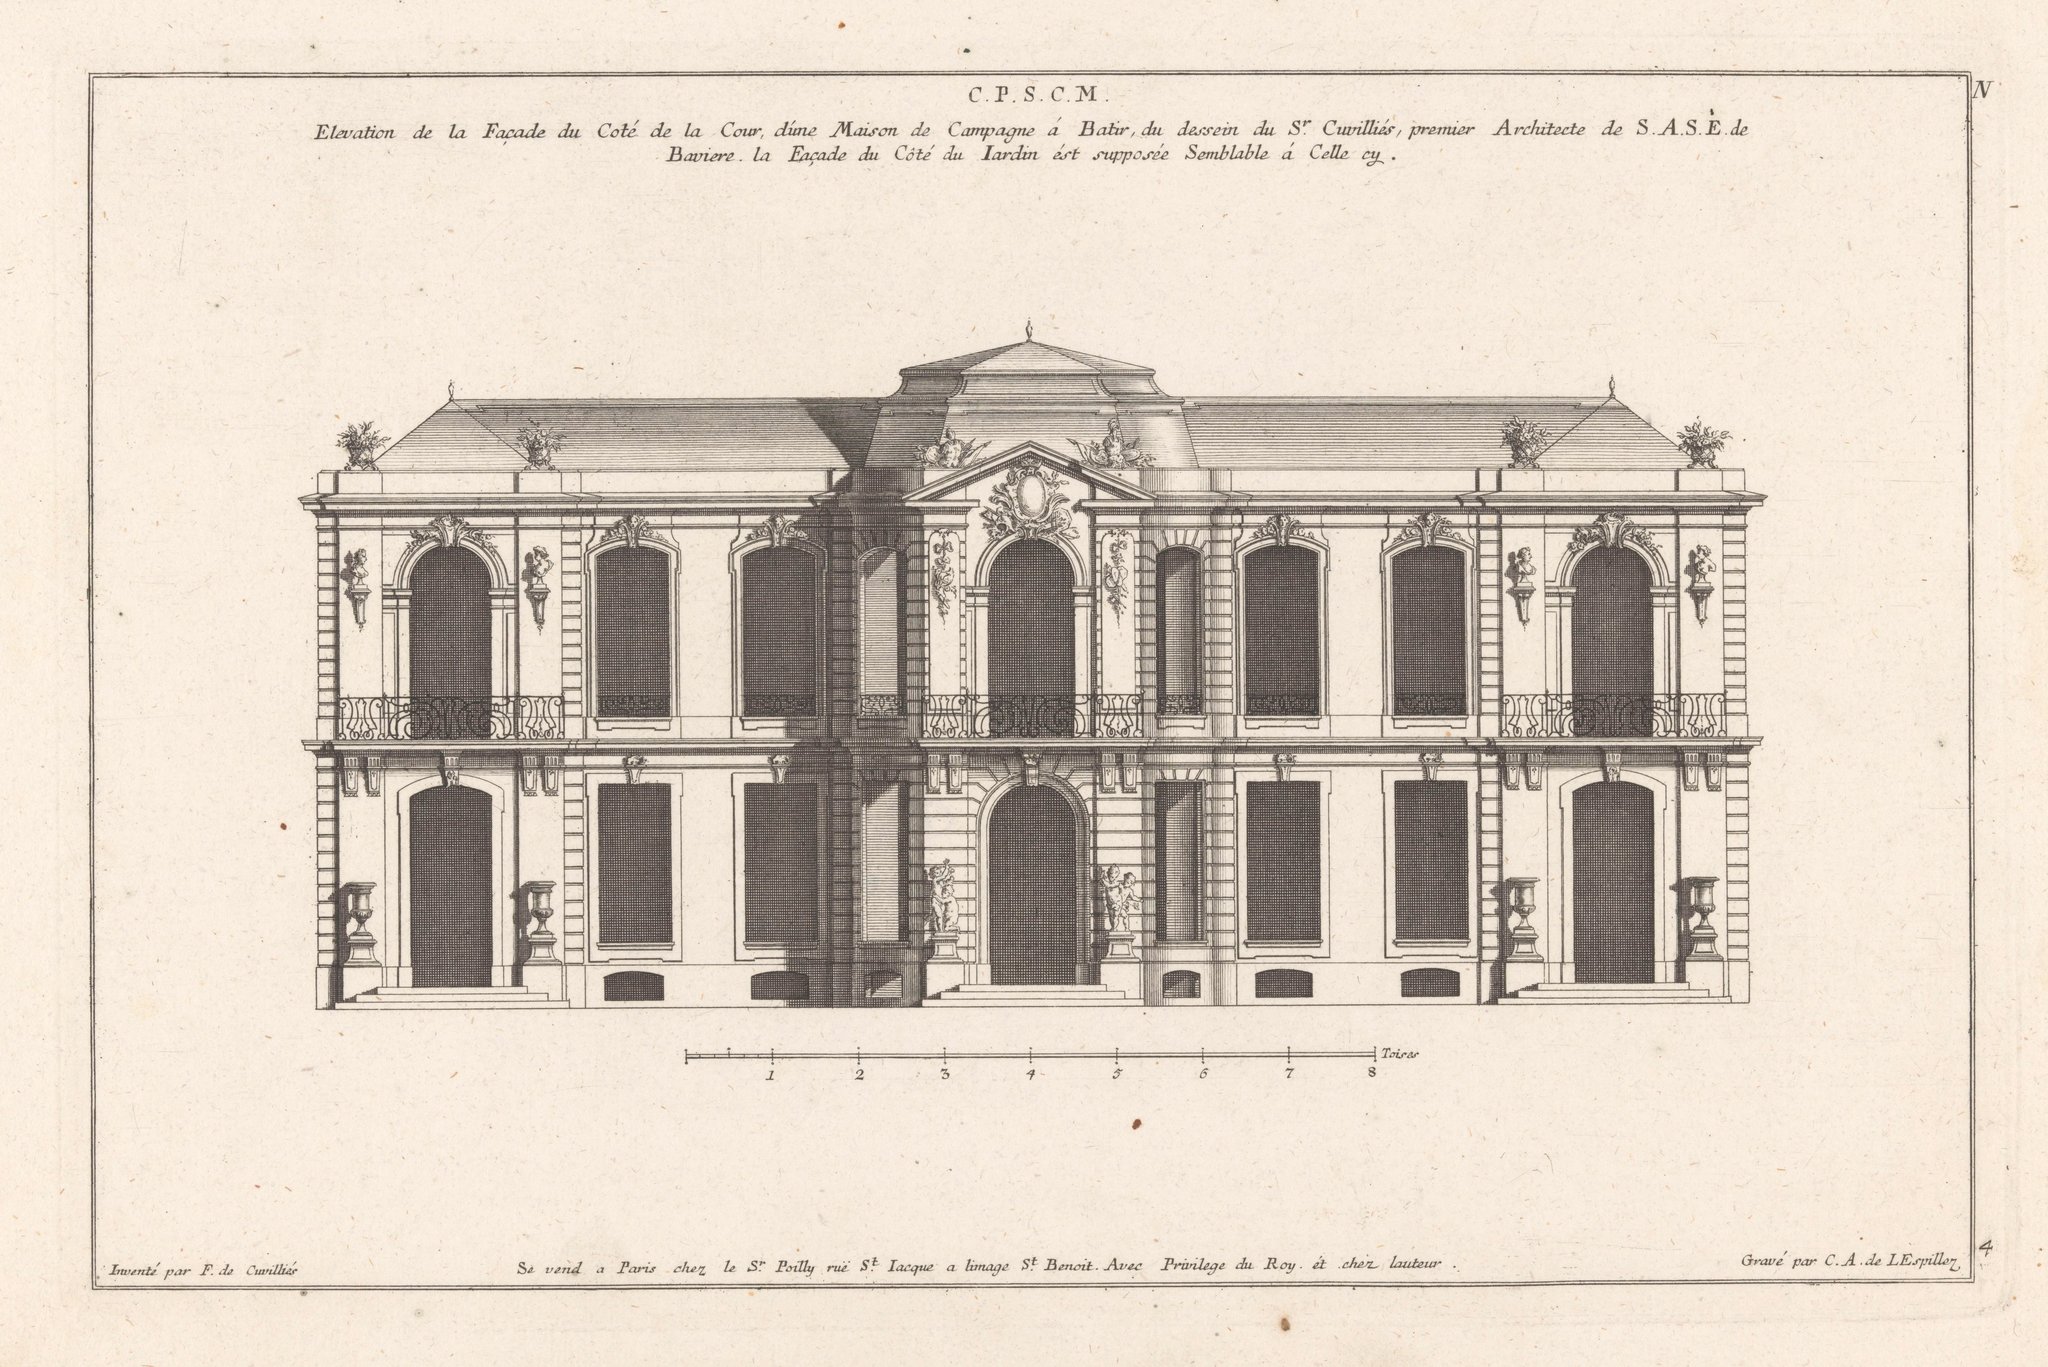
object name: ornament print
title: Façade met rondbogen en balkons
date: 1745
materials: paper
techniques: engraving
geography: germany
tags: arch, archivolt ~ architecture, balcony, façade (of house or building)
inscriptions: collector's mark: Lugt 2228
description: Façade van een landhuis met rondbogen, balkons, vazen, putti en bustes.